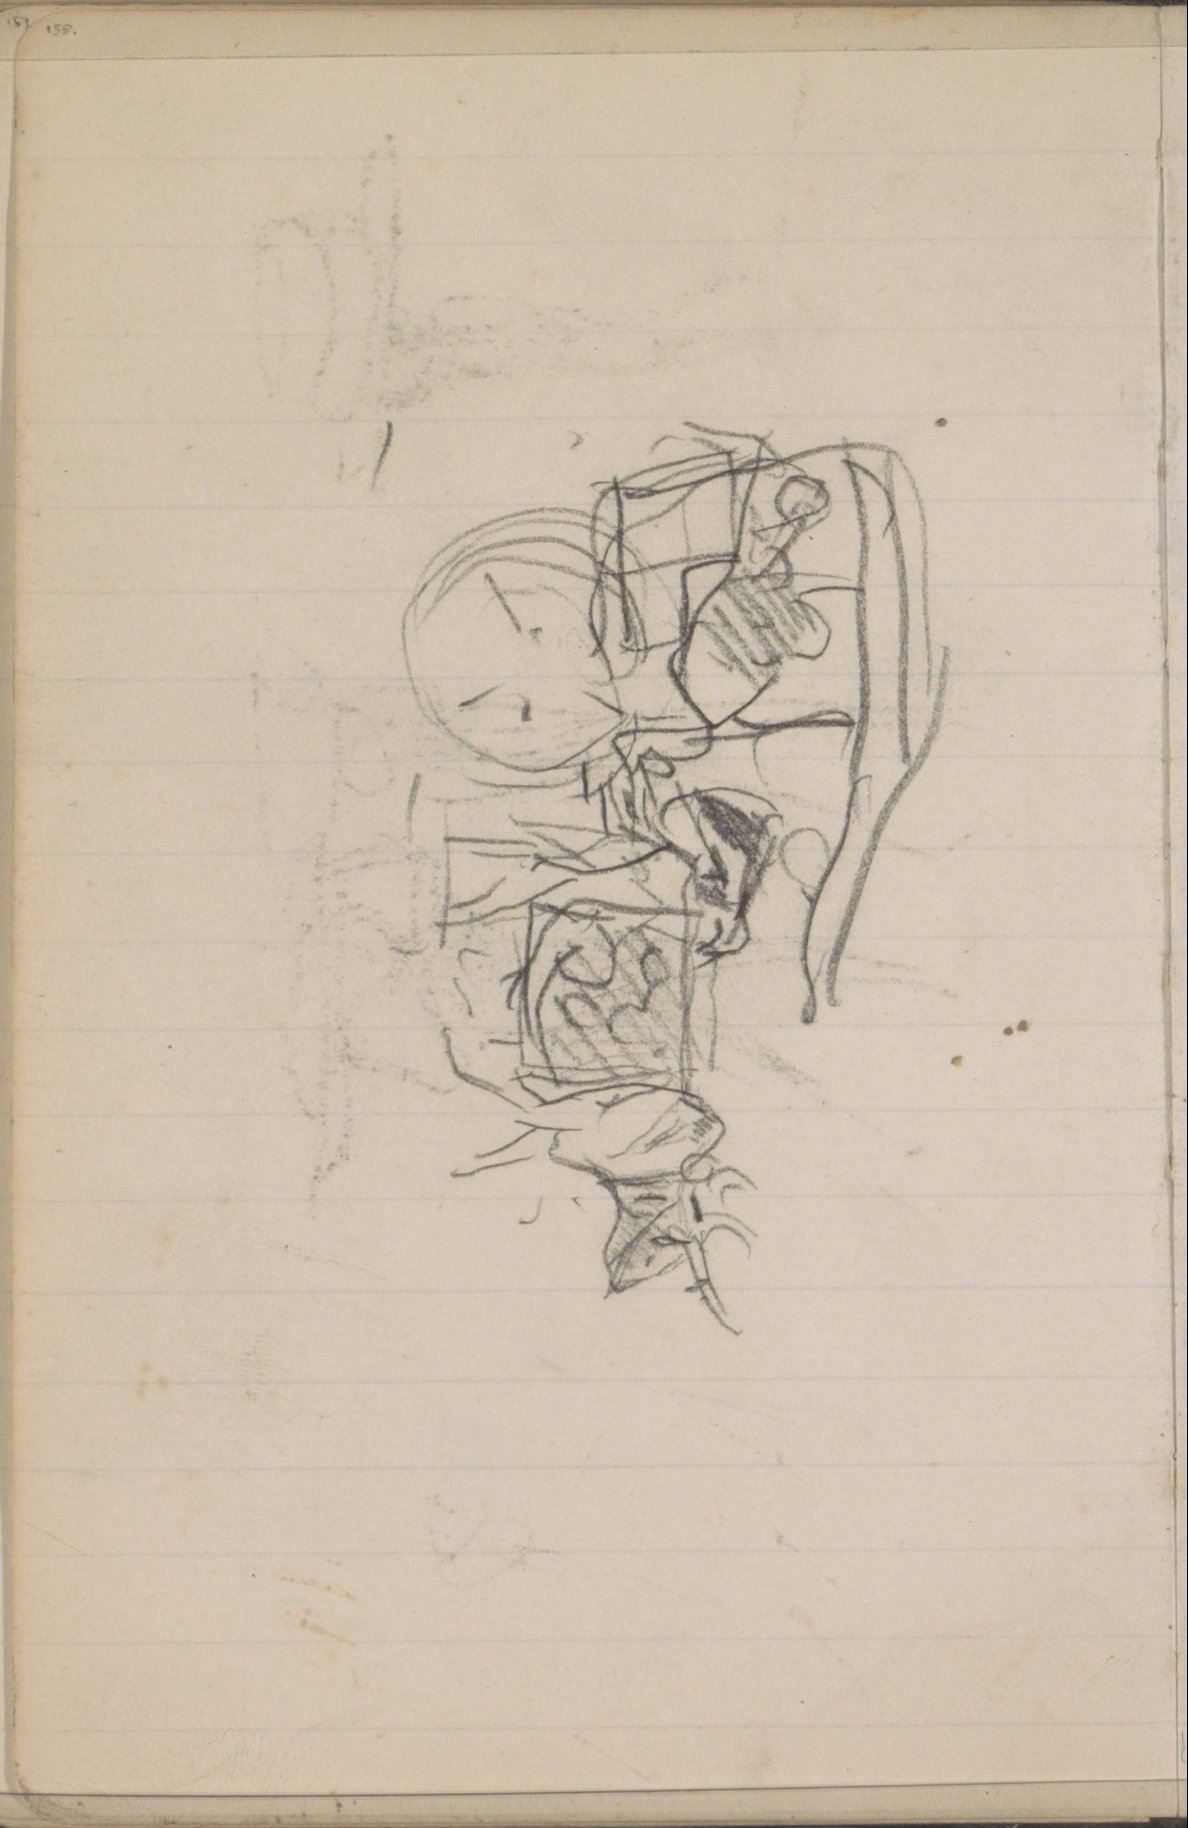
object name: sketchbook leaf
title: Figuren in een ossenkar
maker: marius bauer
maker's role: draughtsman, print maker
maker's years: 1867-1932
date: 1897-1898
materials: chalk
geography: india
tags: ox, asiatic races and peoples: indians, (farm) wagon, freight wagon, cart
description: Pagina 155 uit een schetsboek met 84 bladen.